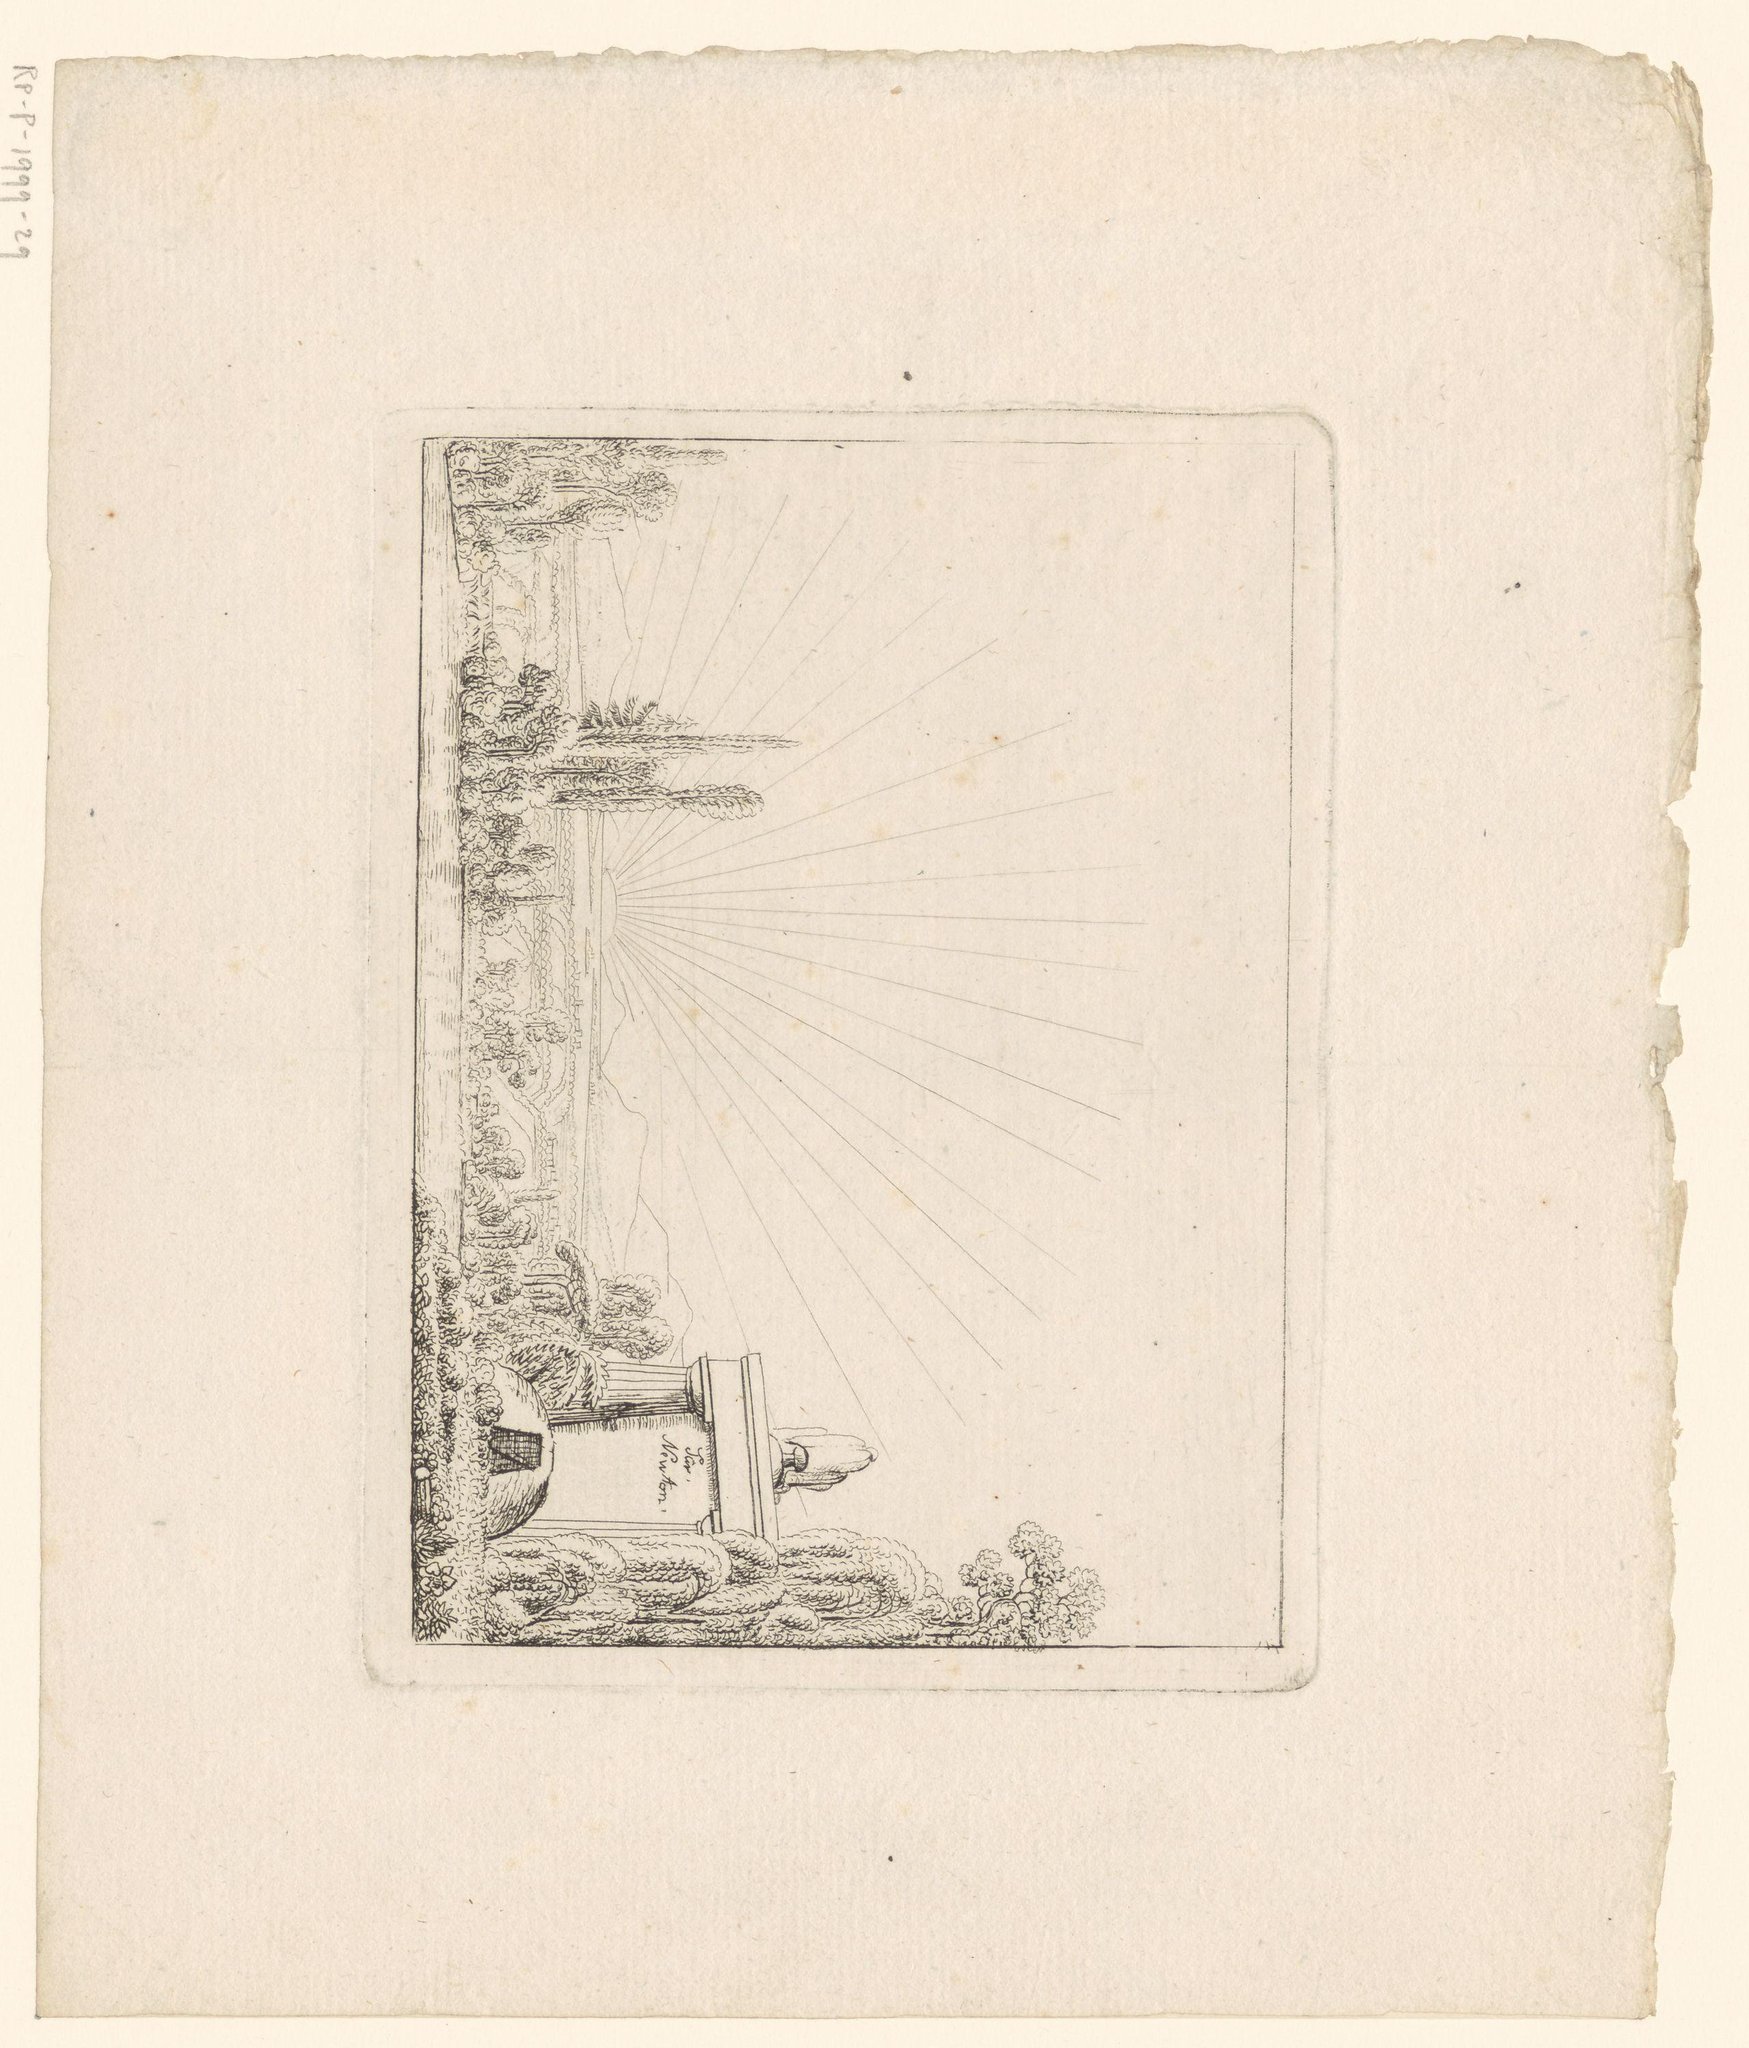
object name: print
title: Landschap met monument voor Isaac Newton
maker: jean koch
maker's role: artist, painter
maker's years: 1765-1806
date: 1776-1806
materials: paper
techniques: etching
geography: germany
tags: sunrise, monument, statue, sunset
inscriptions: collector's mark: Lugt 2760, collector's mark: Lugt 2228